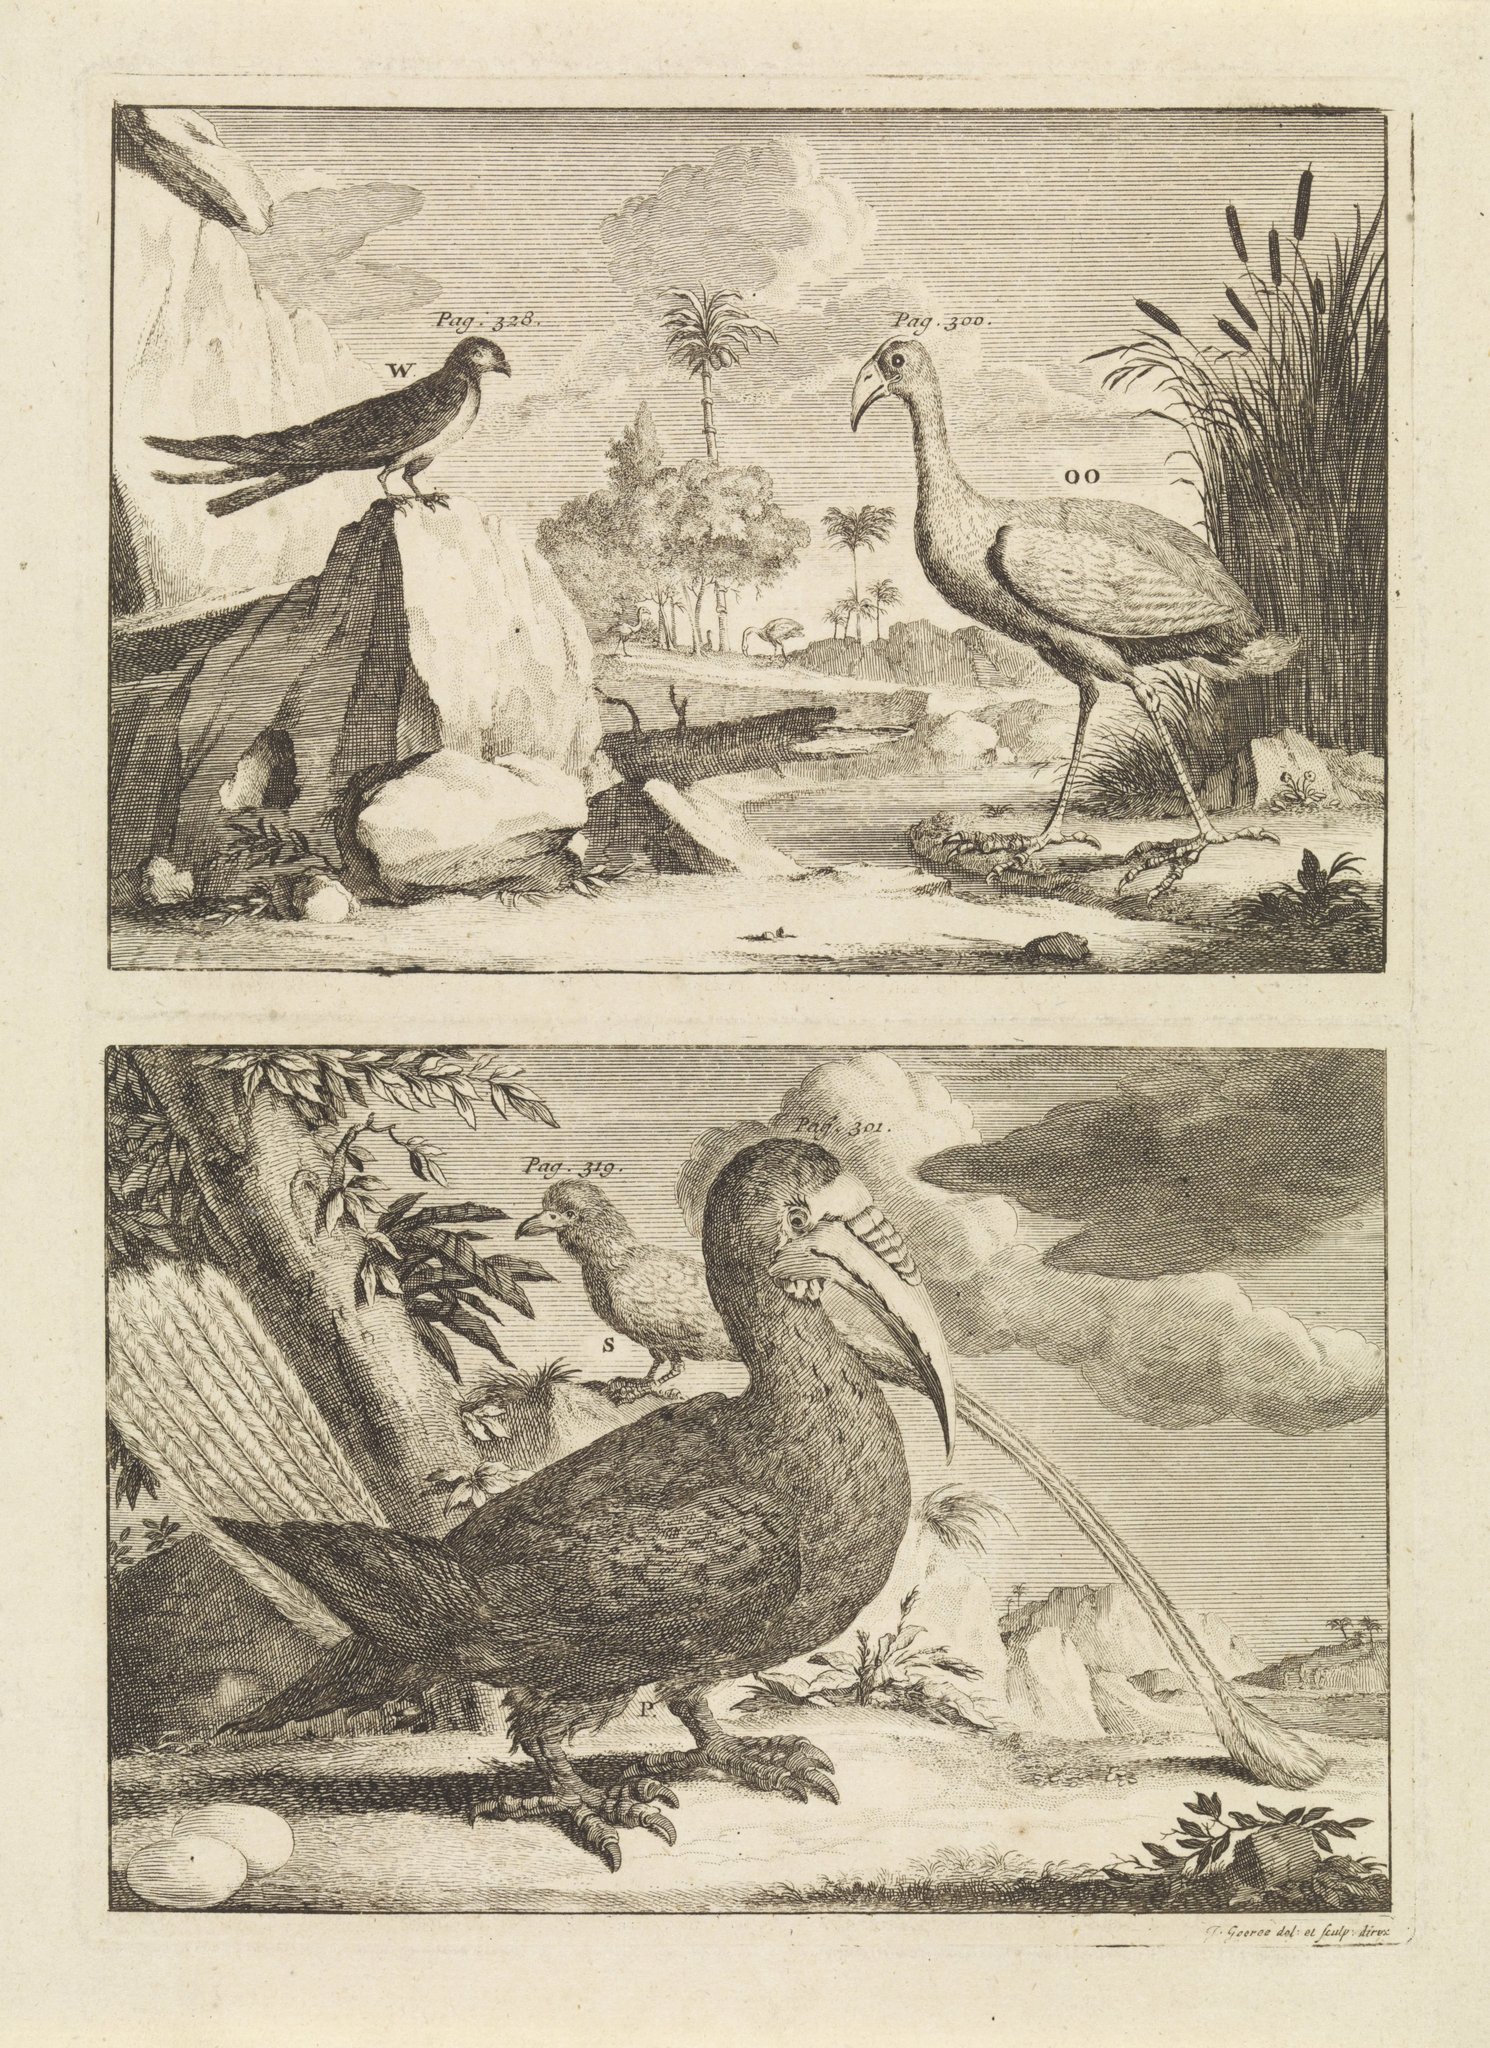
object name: print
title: Vier exotische vogels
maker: jan goeree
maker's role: draughtsman, print maker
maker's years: 1670-1731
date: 1650-1731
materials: paper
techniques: engraving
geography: amsterdam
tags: ornamental birds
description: Een prent van twee platen met vier exotische vogels in het wild. Boven een De afbeelding boven: een Witbuikdwergsalangaan (Collocalia esculenta) en een Australische Purperkoet (Porphyrio porphyrio melanopterus). Onder een Papoeajaarvogel (Aceros plicatus) en daarachter een vrouwtje Vlagstaartijsvogel (Tanysiptera galatea nais).